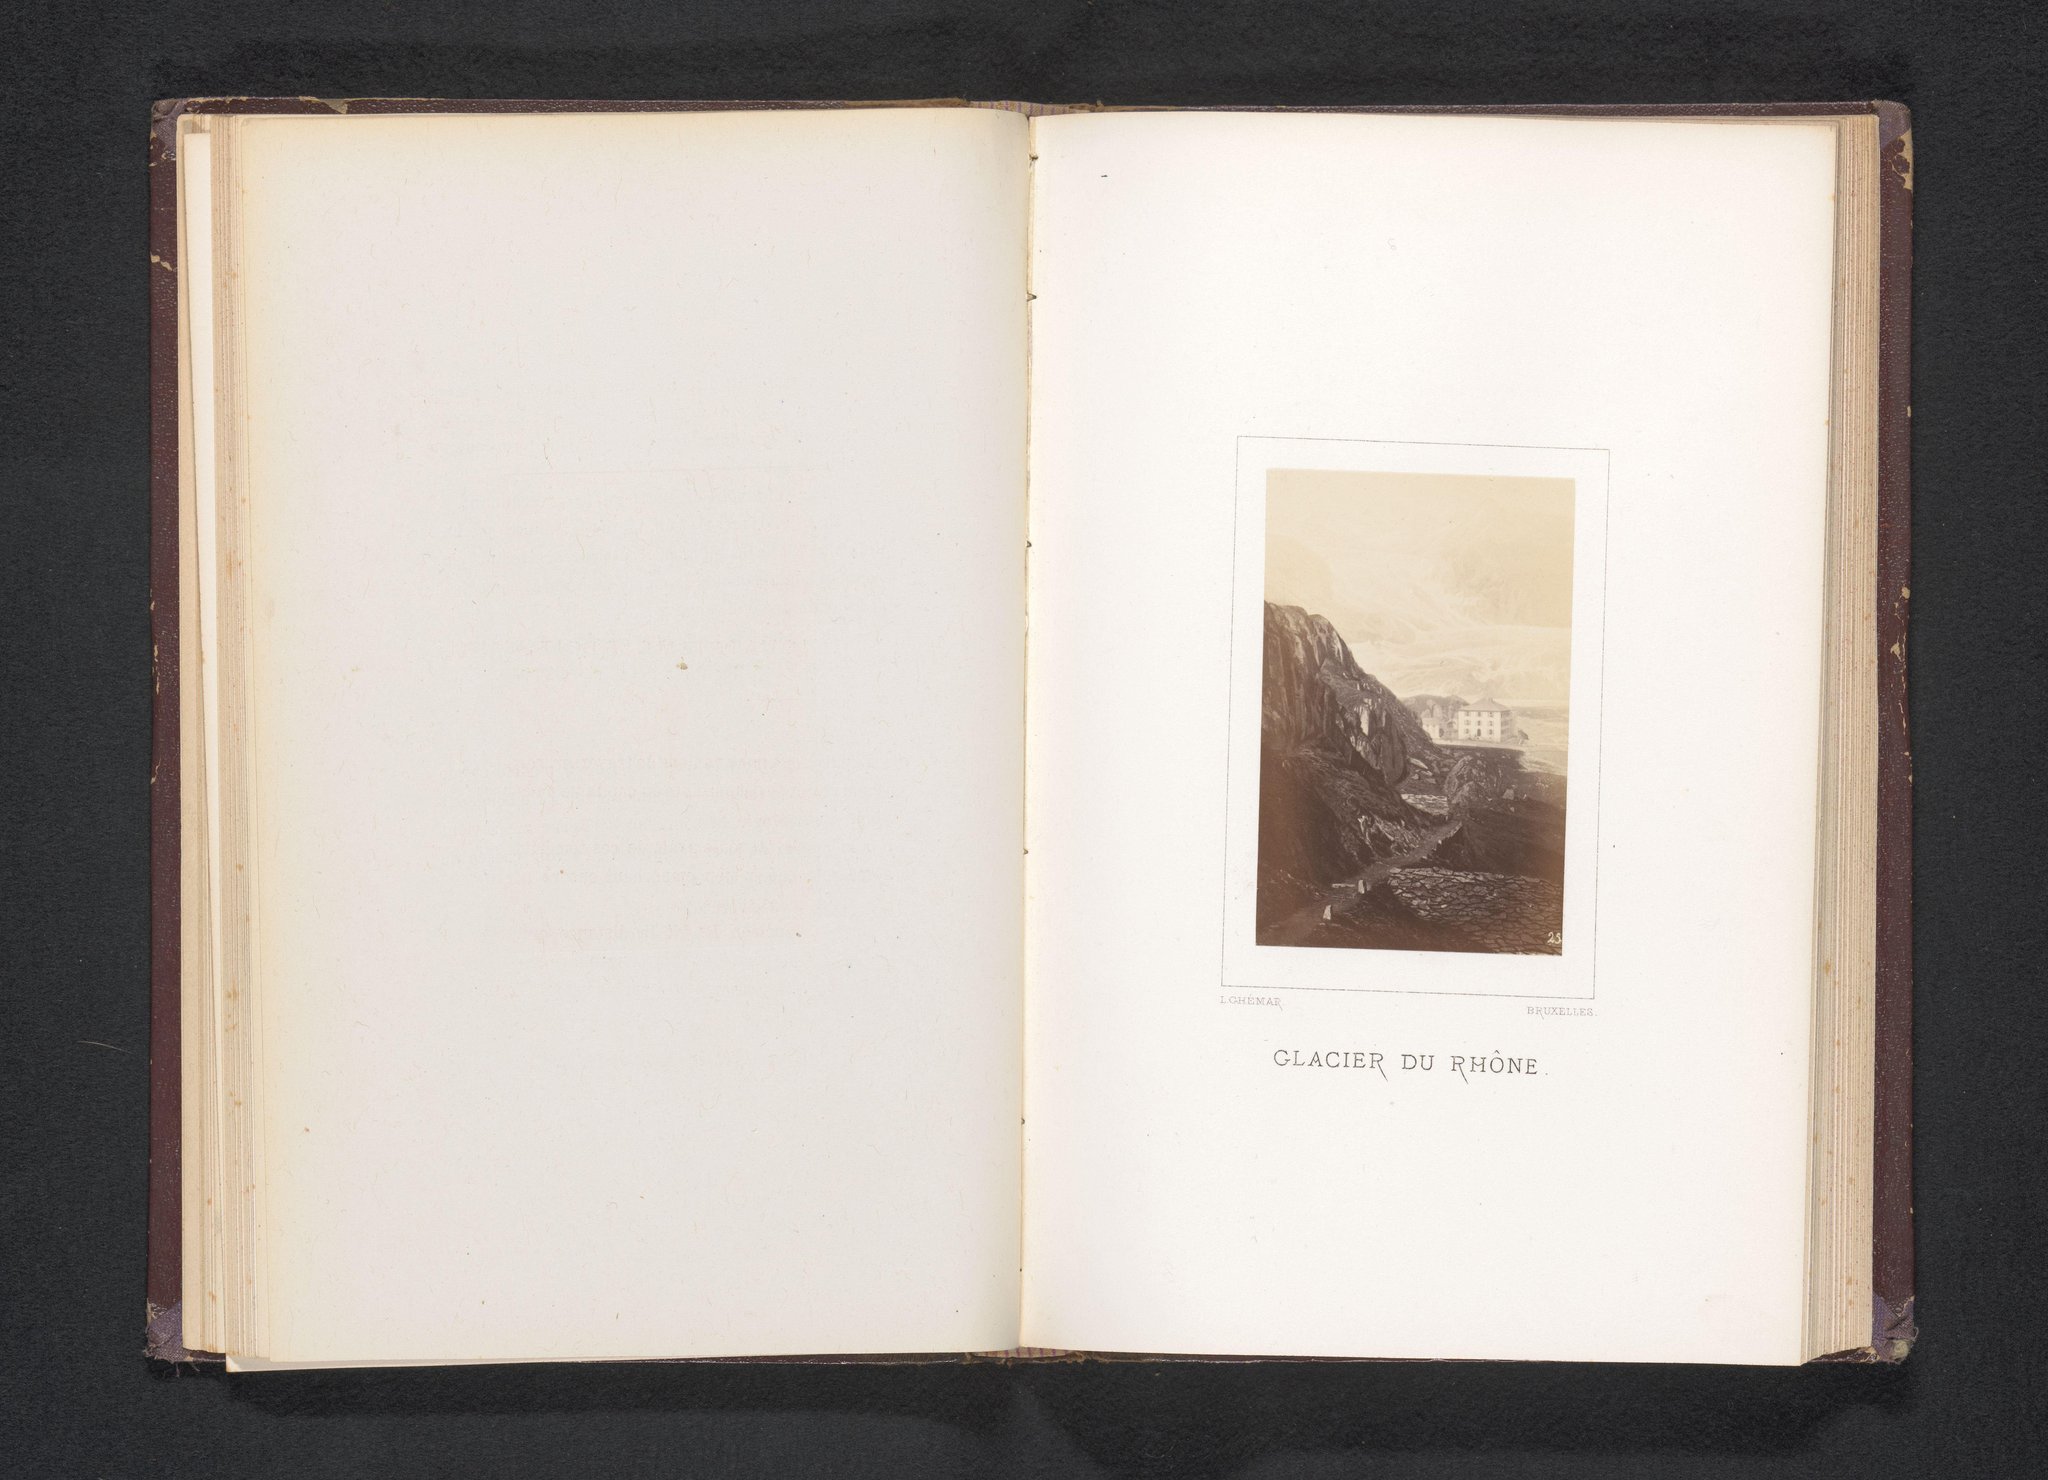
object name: page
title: Gezicht op de Rhônegletsjer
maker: louis ghémar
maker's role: draughtsman, print maker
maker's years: 1819-1873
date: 1863-1868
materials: photographic support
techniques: albumen print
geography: wallis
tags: glacier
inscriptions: inscription: ‘Bruxelles’